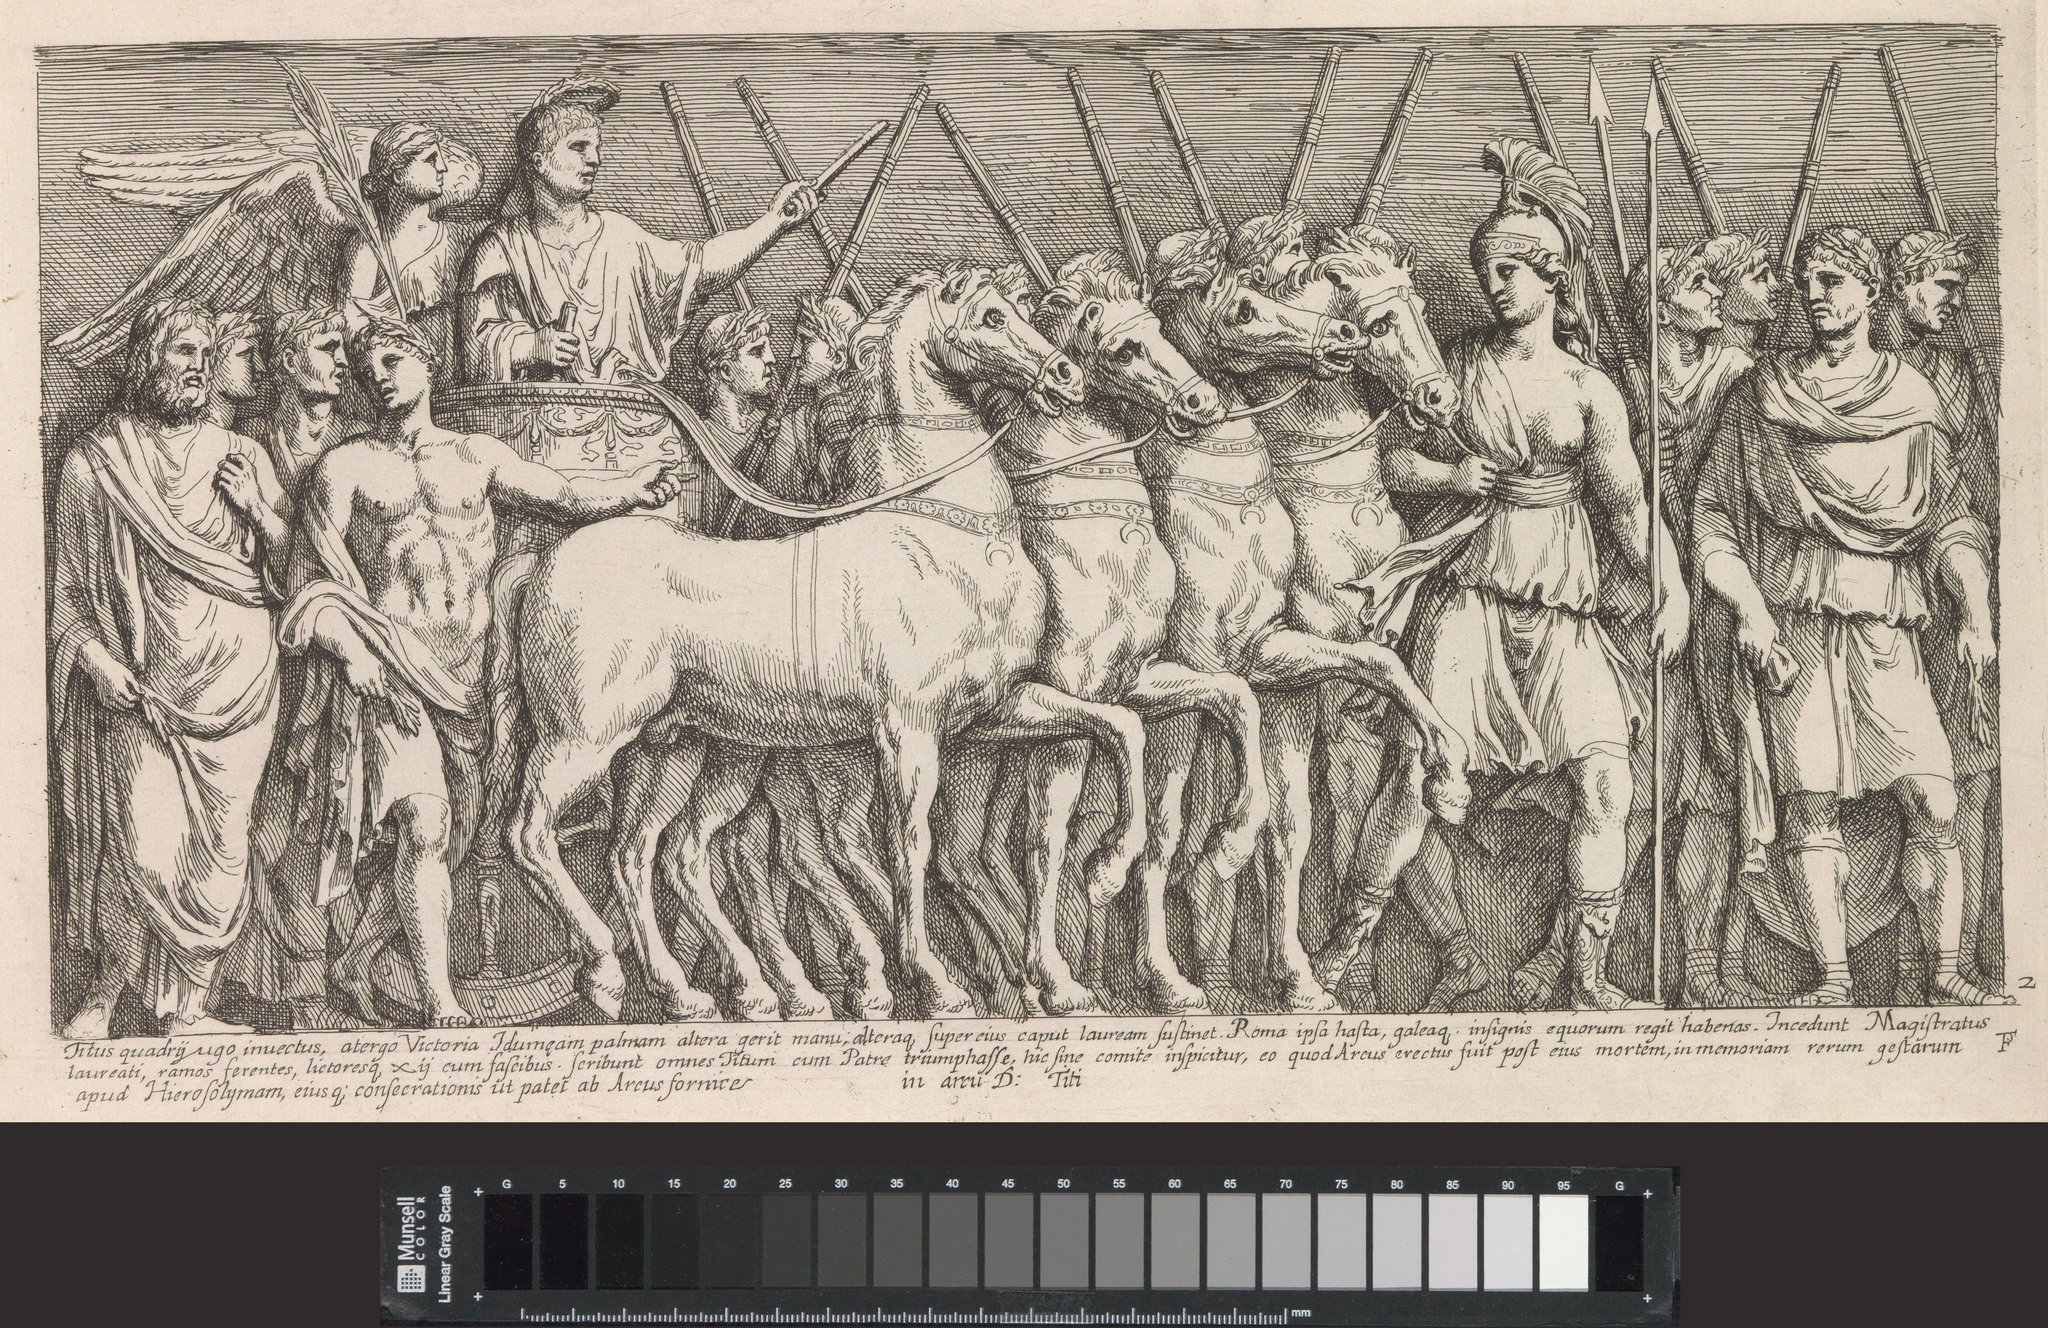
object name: print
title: Romeinse gebeeldhouwde reliëfs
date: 1645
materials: paper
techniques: etching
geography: paris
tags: military demonstrations, triumphal entry and public reception, pageant, 'entrée solennelle', 'joyeuse entrée', piece of sculpture, reproduction of a piece of sculpture, (story of) the emperor titus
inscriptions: number: ‘29’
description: Reliëf met een triomftocht voor de Romeinse keizer Titus. Titus staat op een triomfwagen die wordt voortgetrokken door vier paarden. Tekst in het Latijn in ondermarge. Prent maakt deel uit van een album.